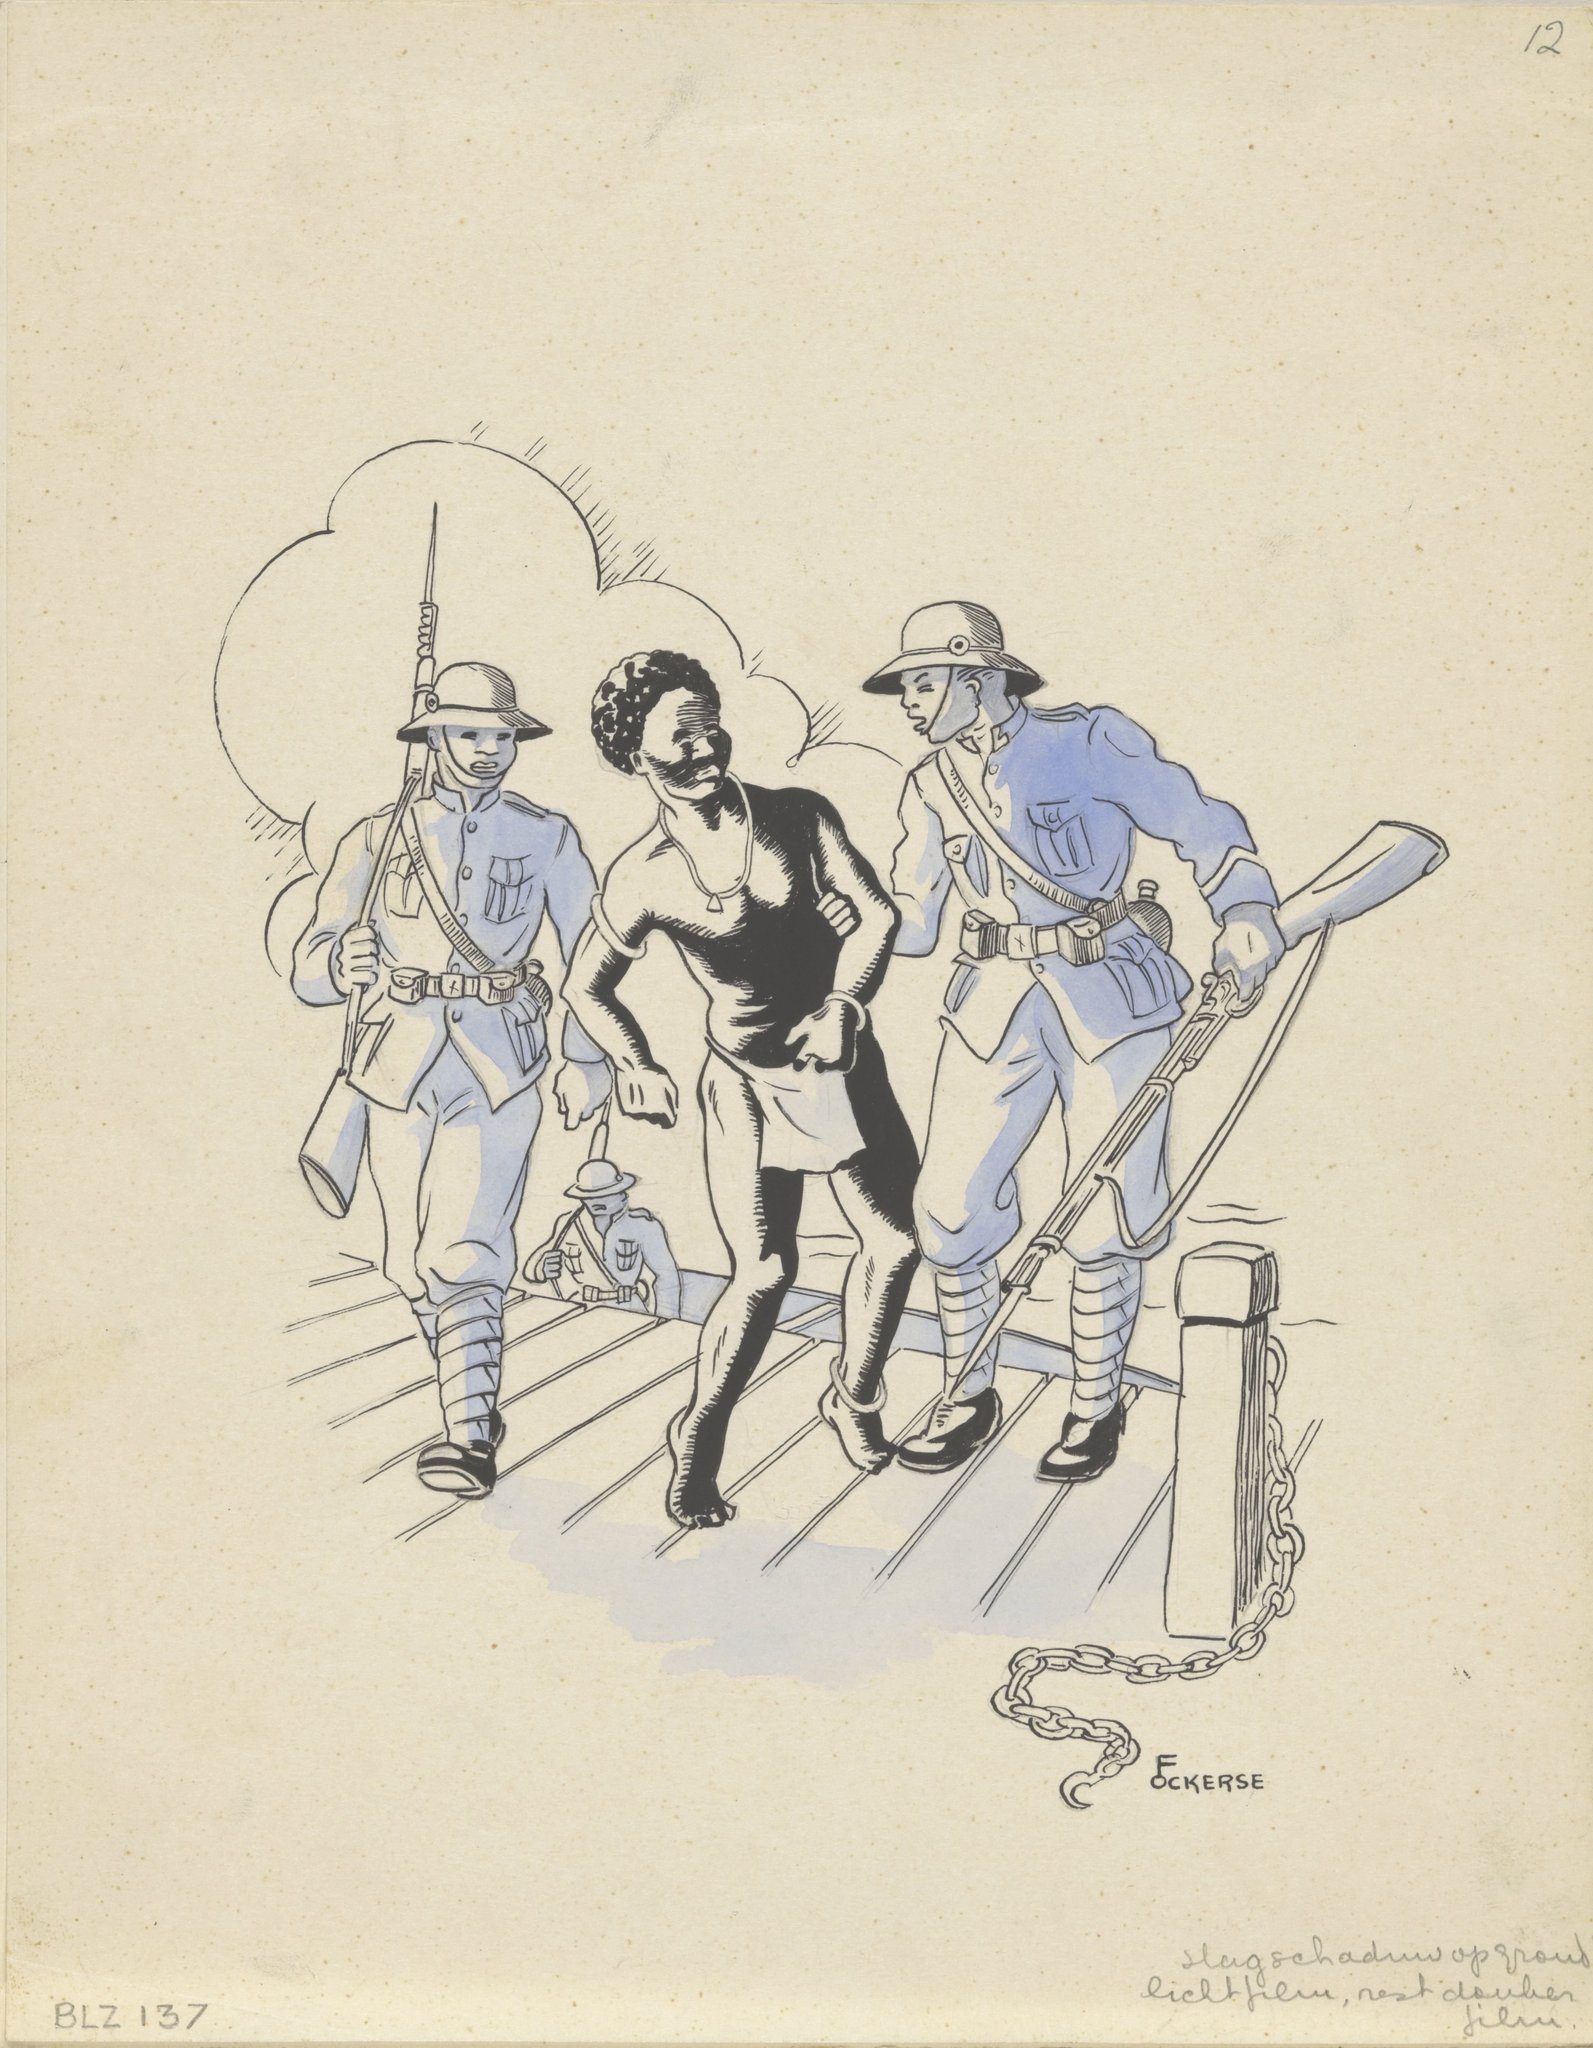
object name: boekillustratie ontwerp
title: Twee soldaten nemen een Nieuw-Guineese man mee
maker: f. ockerse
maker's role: draughtsman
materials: paint, paper, pencil, watercolor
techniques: brush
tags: soldiers and civilians, pier, quay, wharf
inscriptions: label: ‘WERKBO[...]/ Datum’, :, signature: ‘F/ OCKERSE’, annotation: ‘12/ BLZ. 137’, collector's mark: Lugt 2228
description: Op een aanlegsteiger staan twee soldaten. Eén van hem houdt een Nieuw-Guineese man onder zijn arm vast. In de achtergrond staat een derde soldaat.